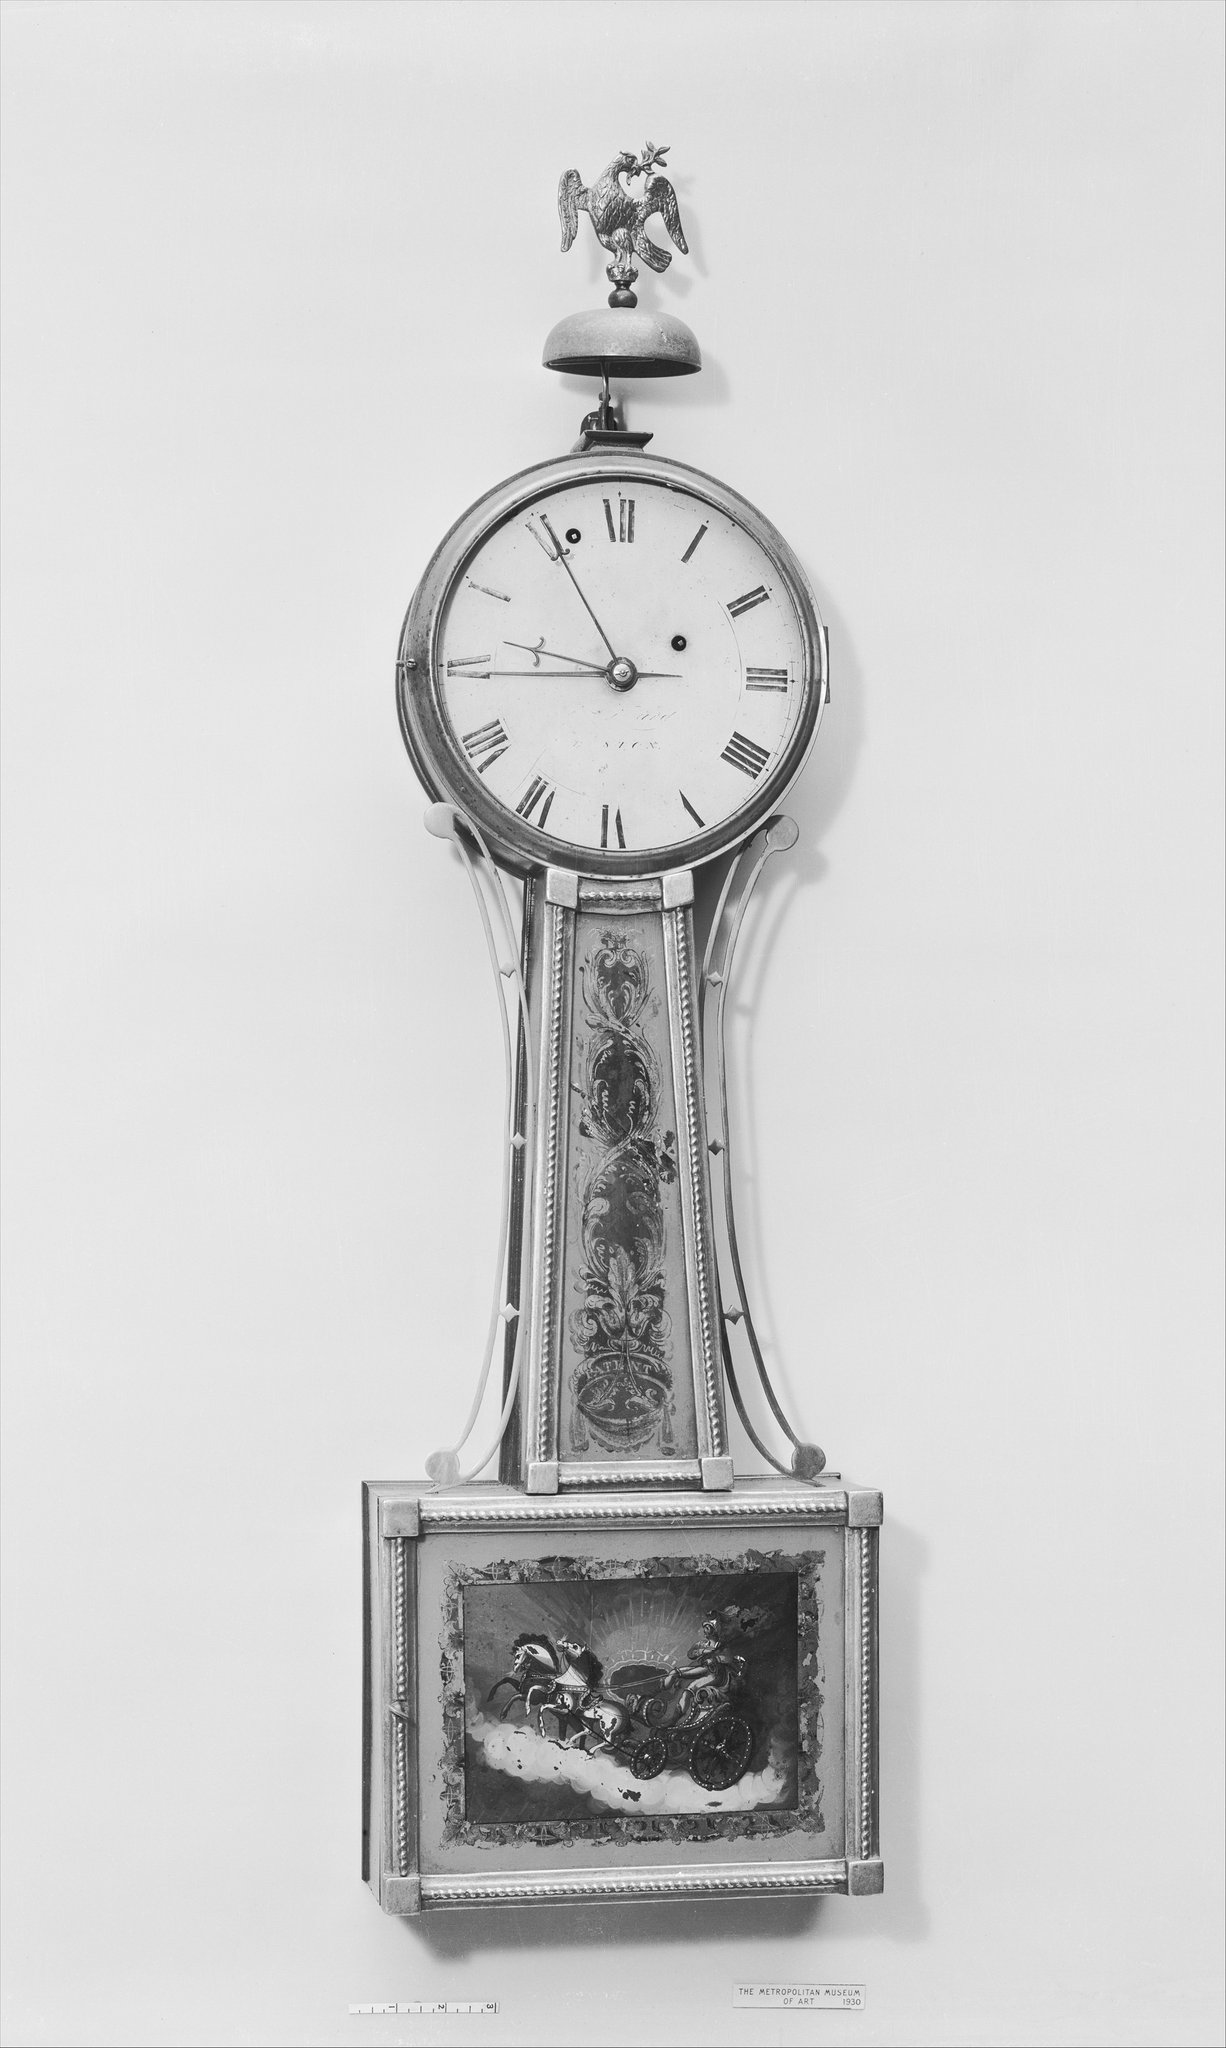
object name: banjo clock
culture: american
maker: aaron willard jr.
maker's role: maker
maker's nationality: american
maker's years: 1783-1864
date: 1825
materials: gesso, gilt, wood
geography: united states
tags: eagles,horses,chariots